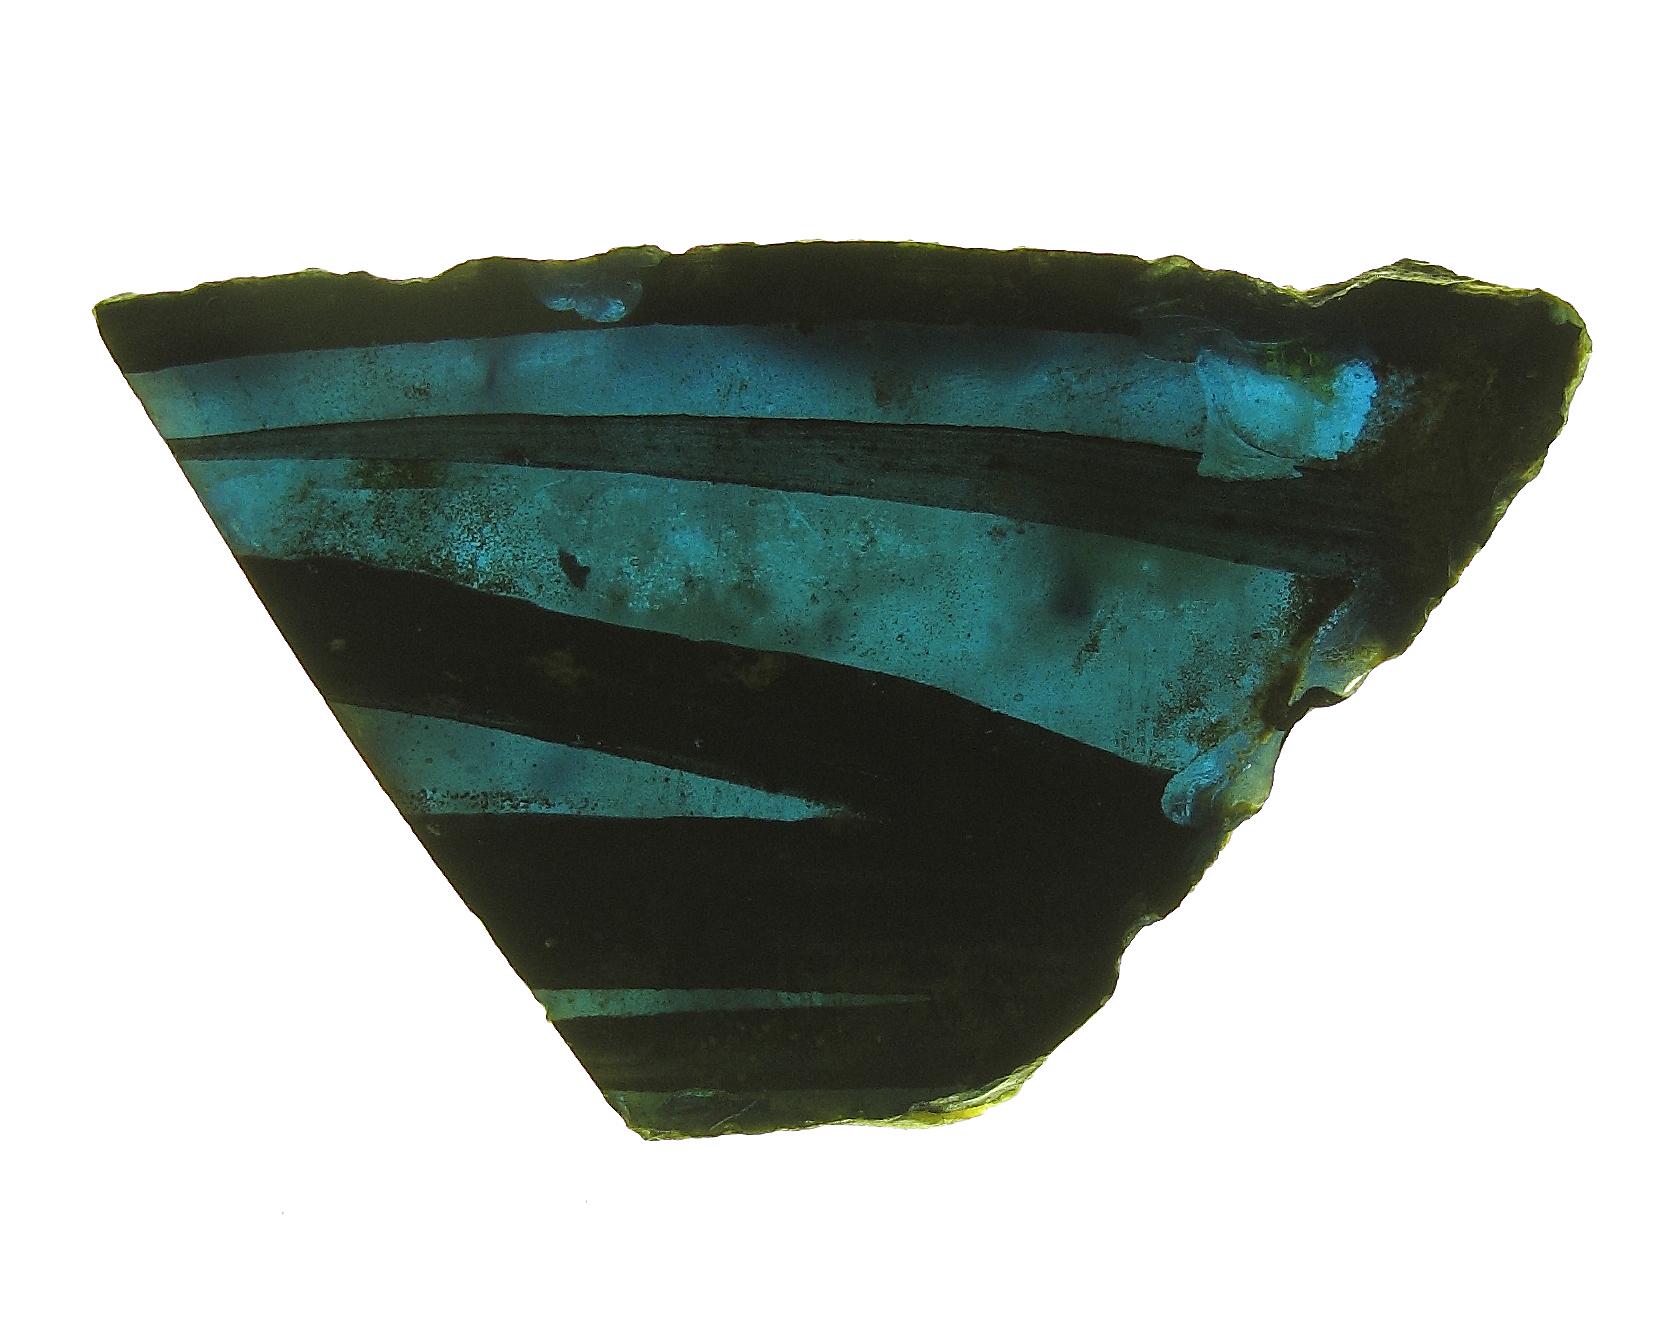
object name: fragment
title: Glass Fragment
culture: european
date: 1201-1400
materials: glass, metal